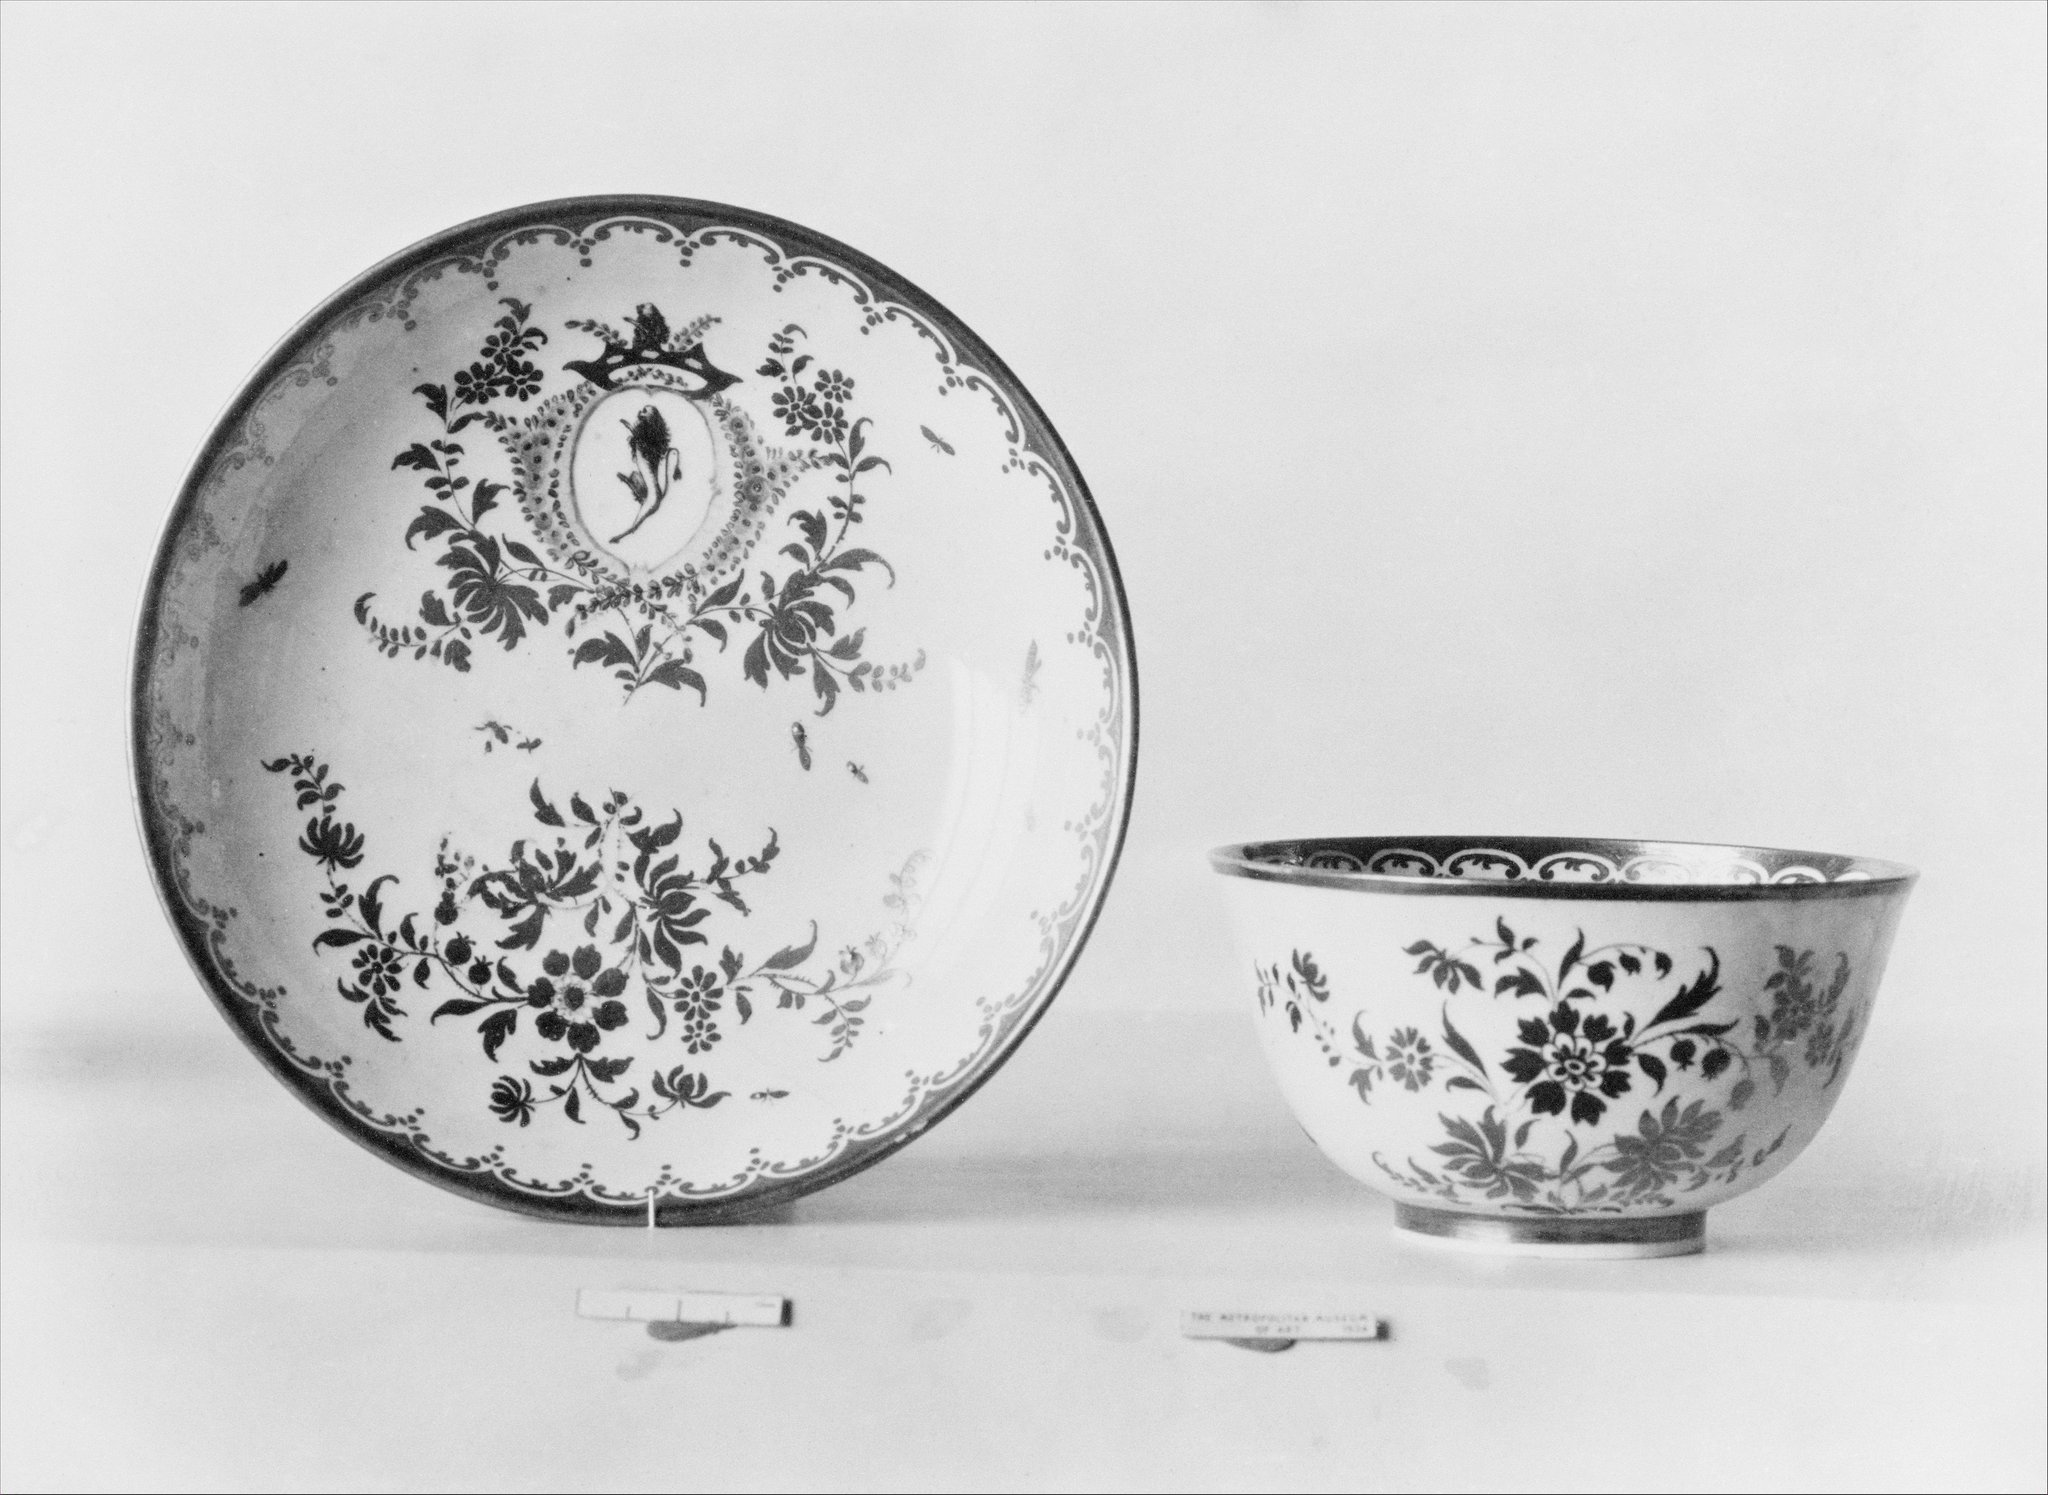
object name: teabowl and saucer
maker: cozzi manufactory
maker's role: factory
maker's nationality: italian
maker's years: 1764-1812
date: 1770-1775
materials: hard paste porcelain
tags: birds,flowers